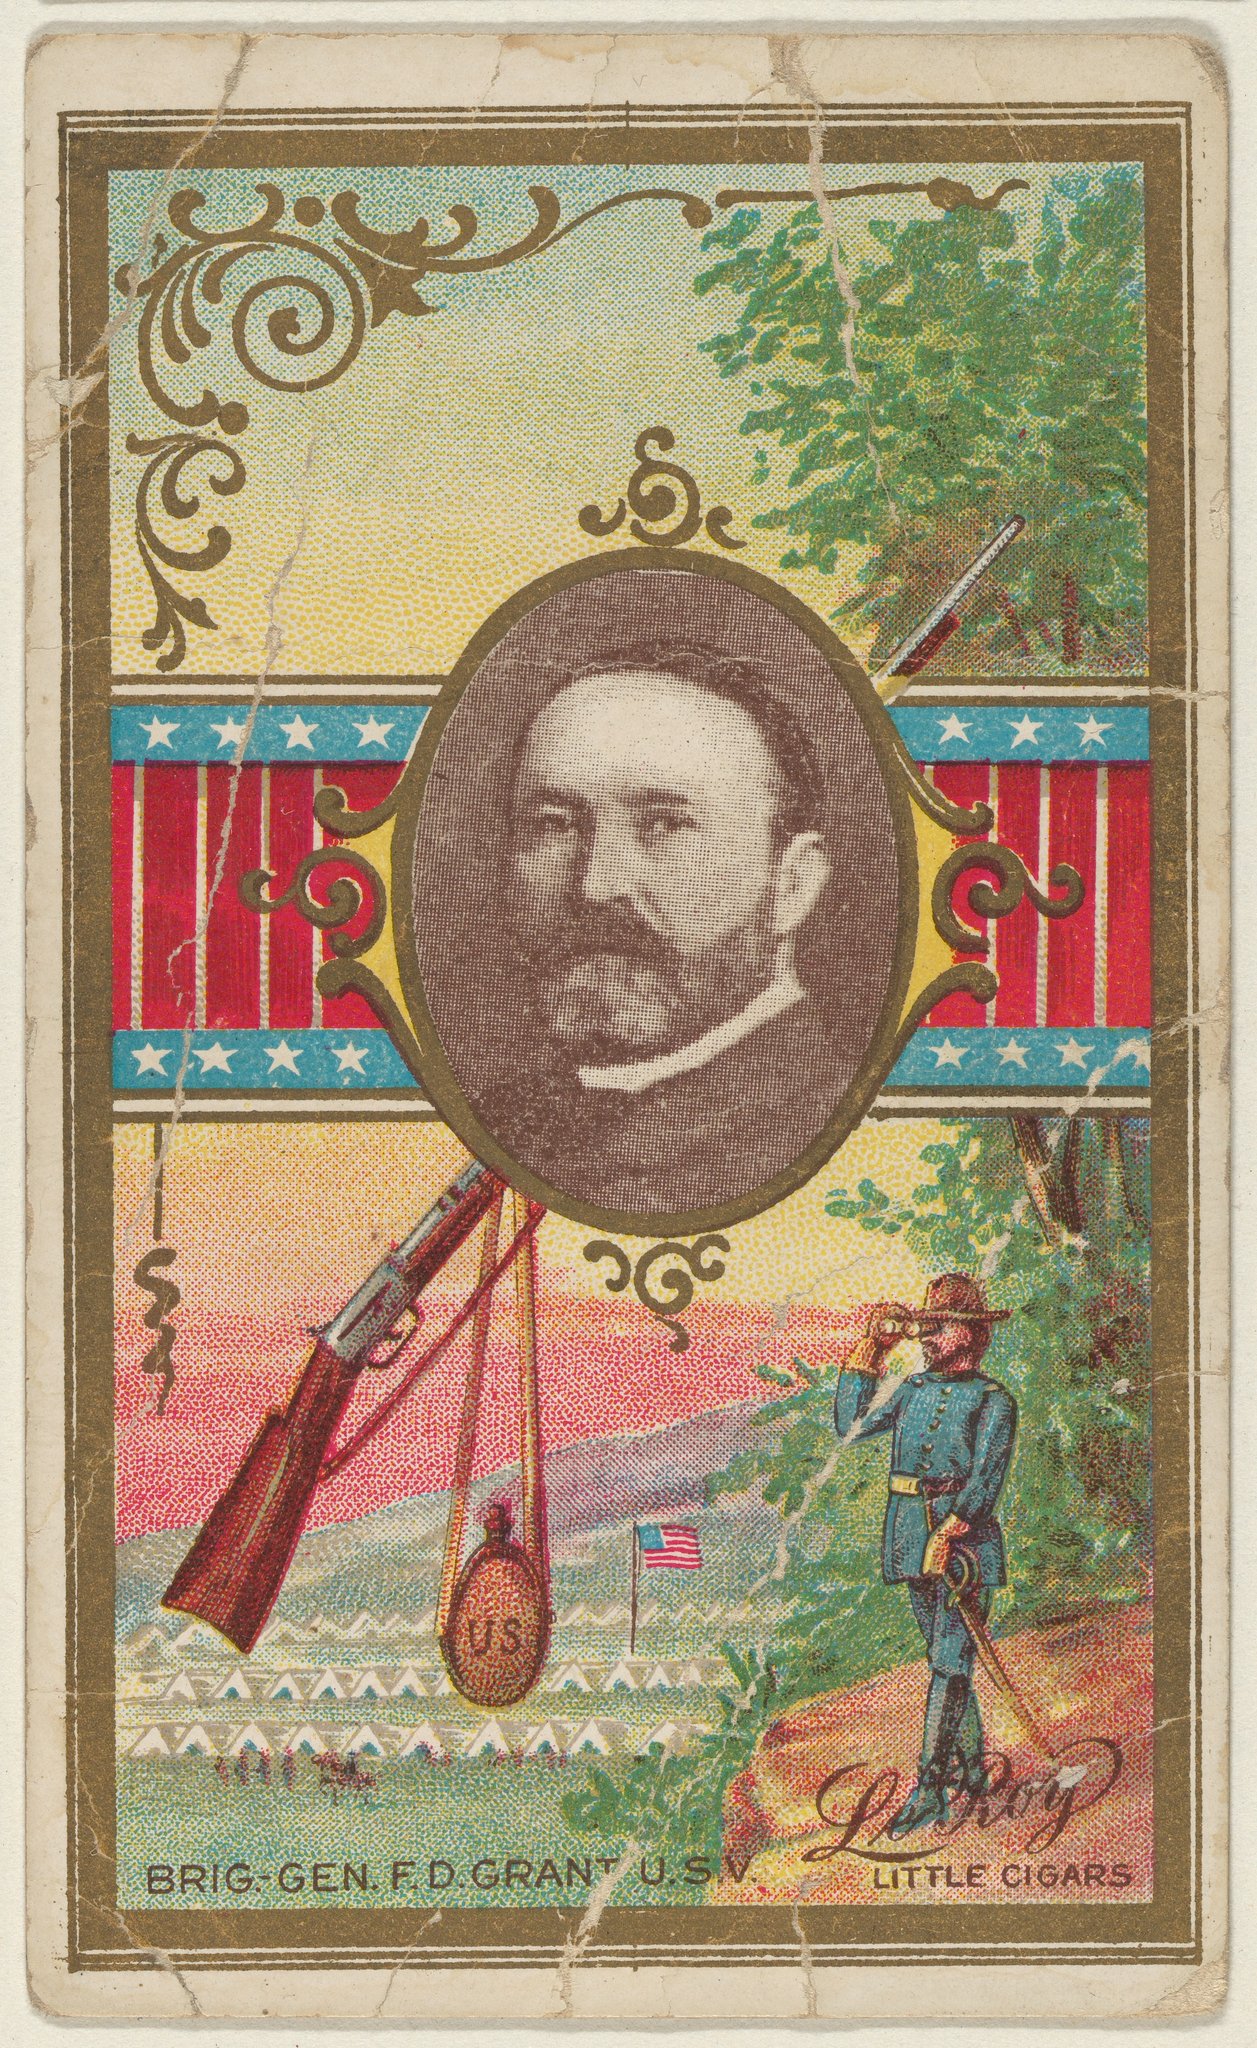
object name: print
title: Brigadier General Frederick D. Grant, U.S. Volunteers, from the "Generals" series (T63), issued by LeRoy Little Cigars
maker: leroy little cigars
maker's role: publisher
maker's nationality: american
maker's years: 1850-1950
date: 1898-1901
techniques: color lithograph